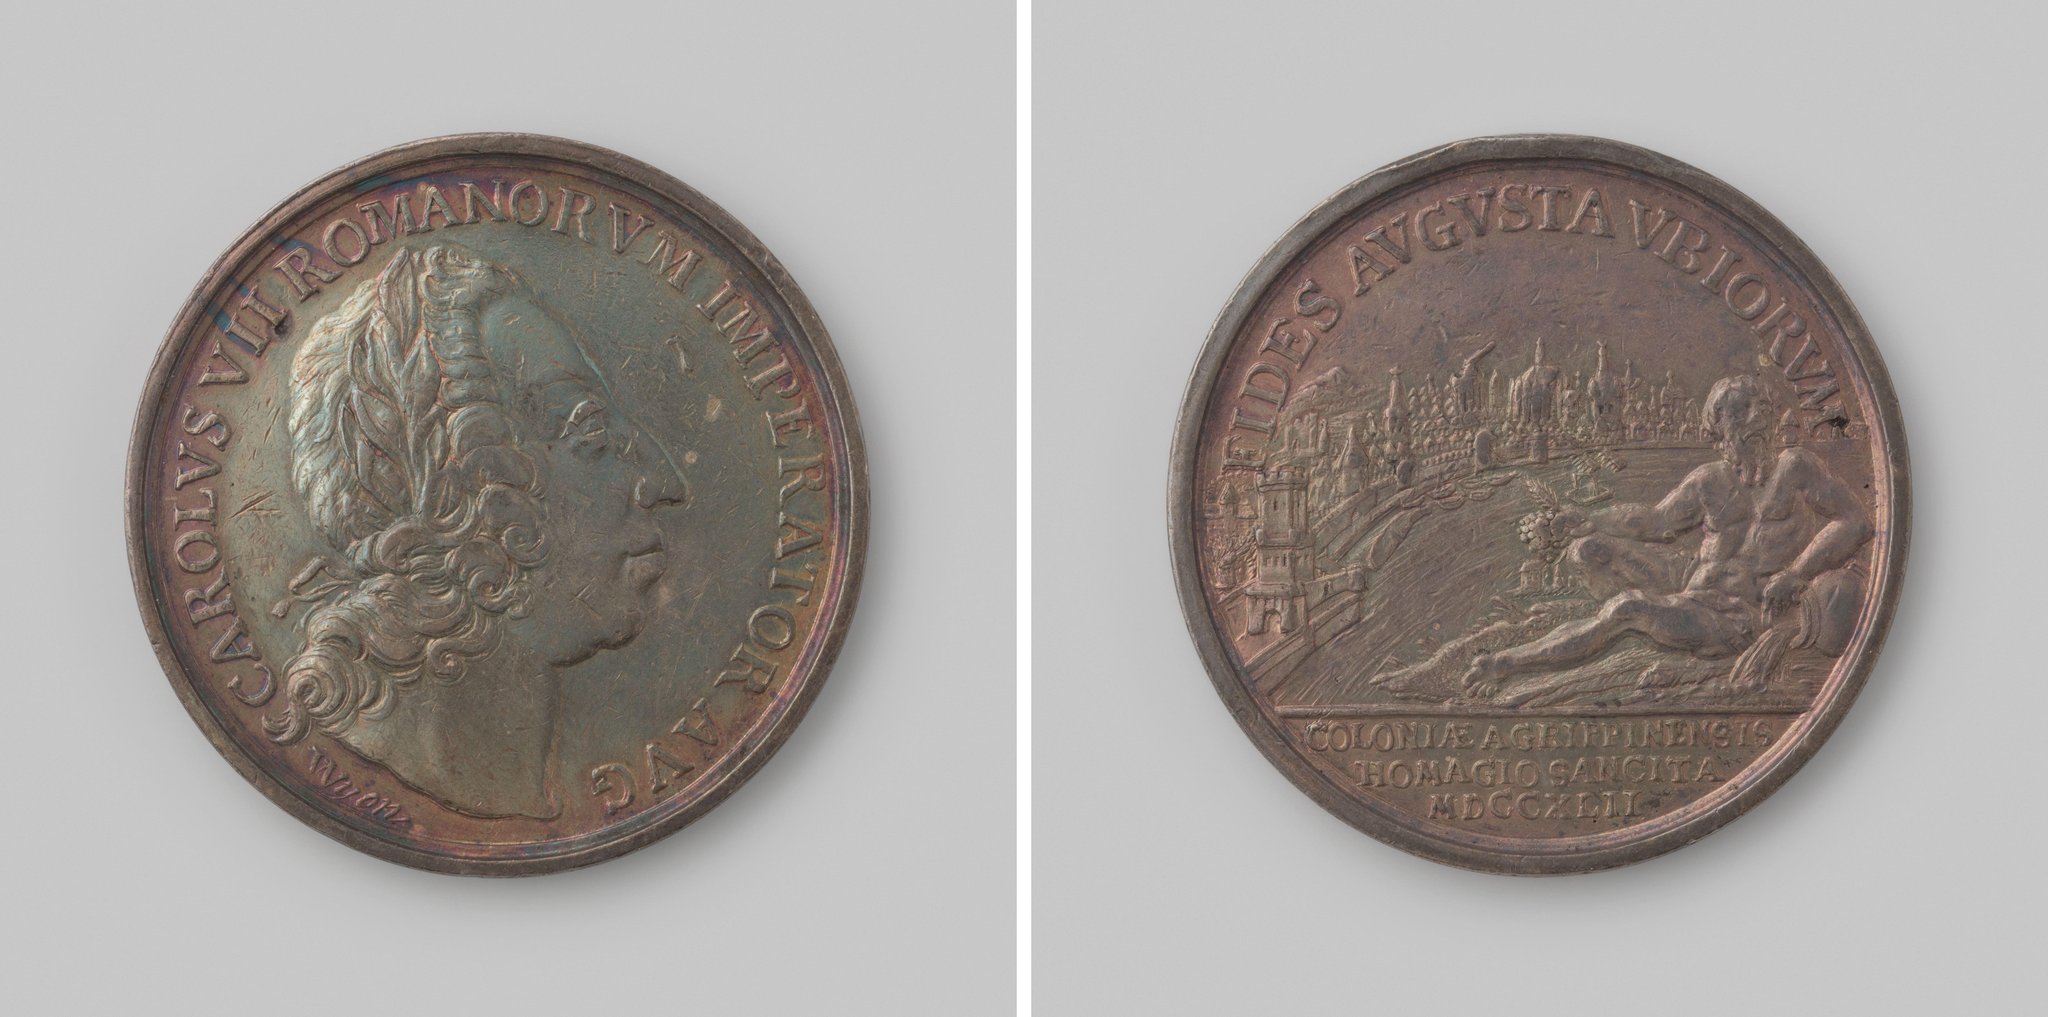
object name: history medal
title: Keulen en de kroning van Keizer Karel VII 1742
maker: peter george wyon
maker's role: die cutter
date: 1742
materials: silver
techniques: striking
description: Zilveren penning, op de voorzijde het portret van Karel VII naar rechts met omschrift, op de keerzijde het aanzicht van Keulen vanaf de Rijn met zittende riviergod, met omschrift en afsnedetekst.